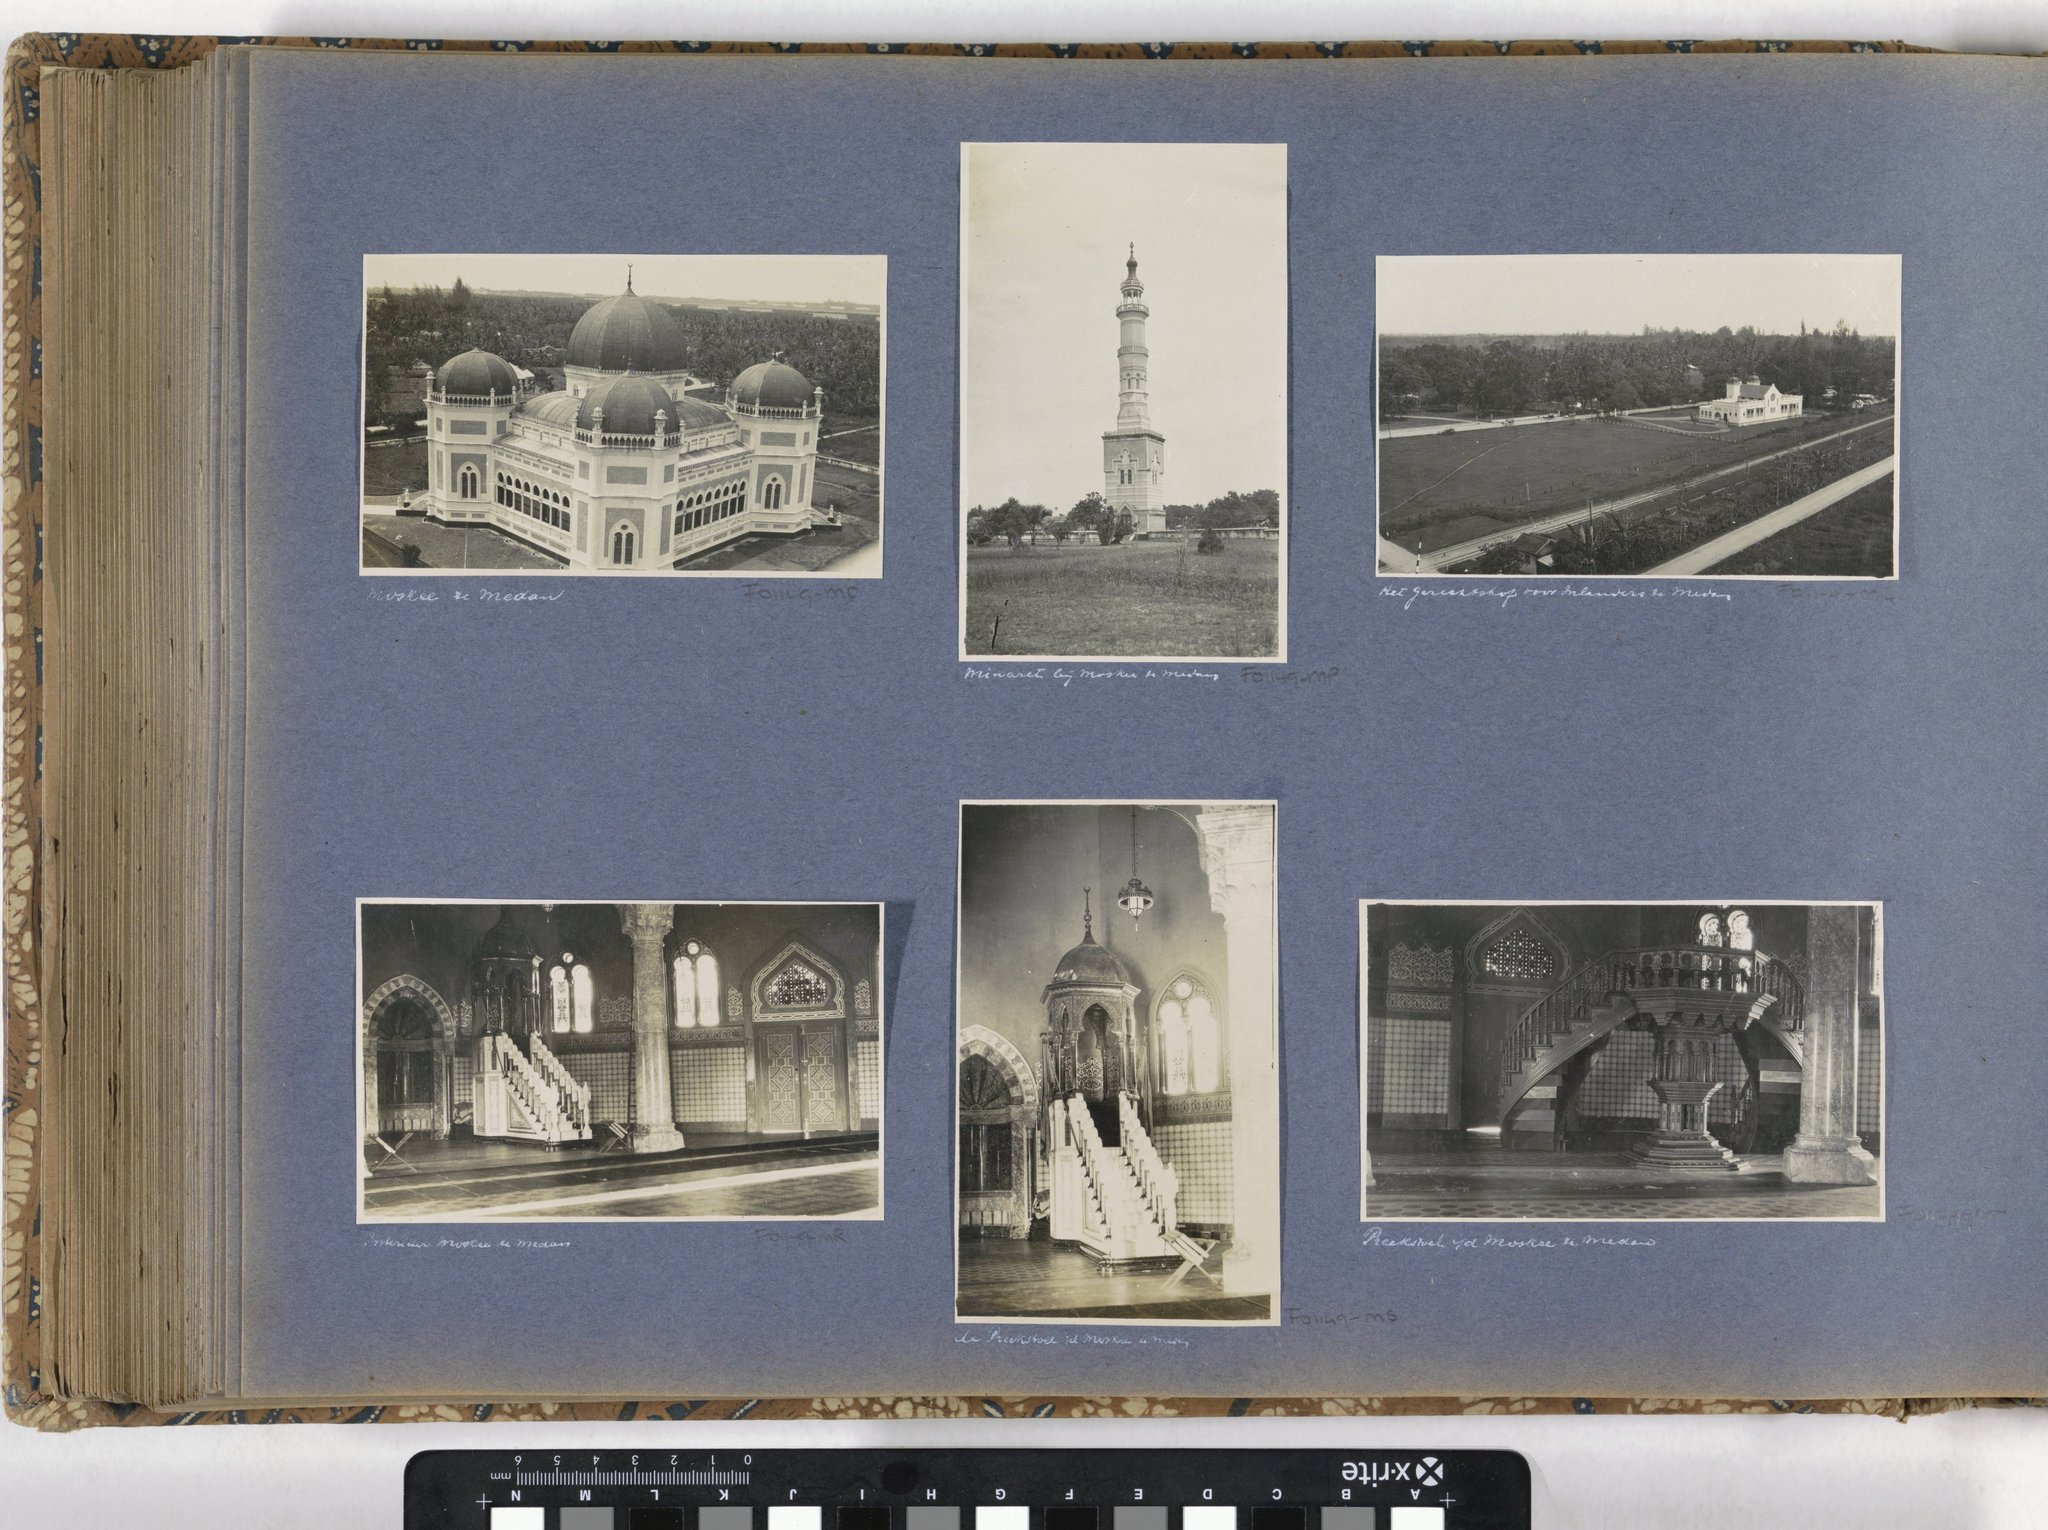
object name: album leaf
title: Exterieur van de Grote Moskee (Masjid Raya Al Mashun) in Medan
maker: Anonymous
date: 1900-1920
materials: paper, photographic support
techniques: gelatin silver print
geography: medan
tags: temple, shrine ~ islam, mohammedanism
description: Onderdeel van reisalbum met foto's van bedrijvigheid en bezienswaardigheden op Sumatra en Java en van de reis naar en van Nederlands-Indië.